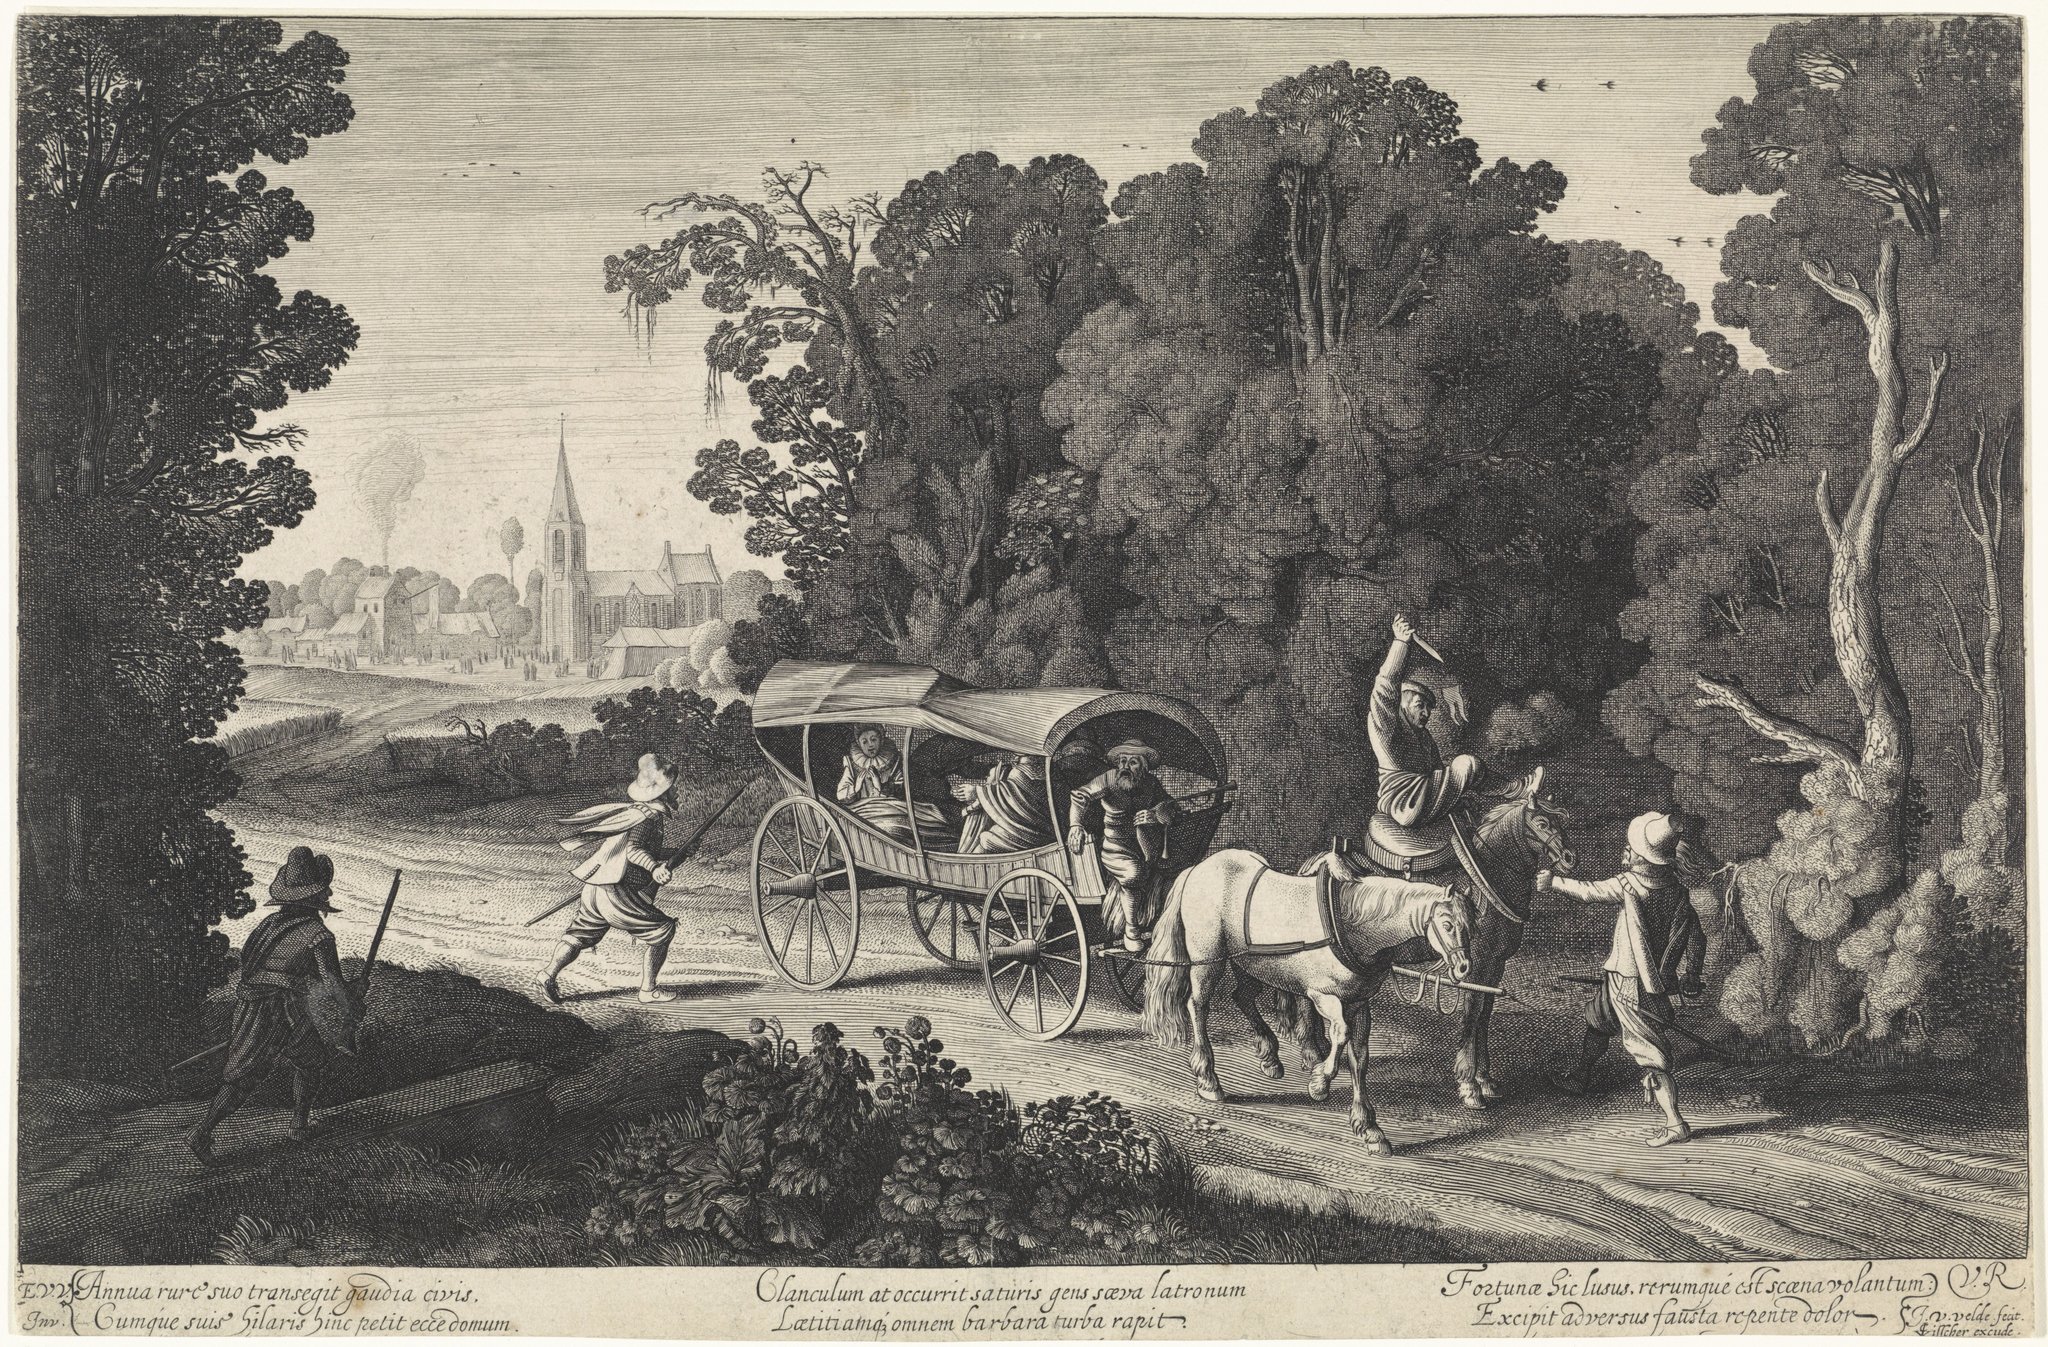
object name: print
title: Overval op een reiswagen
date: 1603-1652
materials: paper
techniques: engraving, etching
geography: amsterdam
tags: traveller(s) attacked by robber(s), covered wagon, hooded wagon, four-wheeled vehicle drawn by two animals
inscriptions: collector's mark: Lugt 240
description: Een reiswagen waarin verschillende figuren wordt overvallen door drie mannen op een landweg tussen bomen. Op de achtergrond een dorp. De bestuurder van de overkapte wagen, op een van de twee paarden, heft zijn mes.